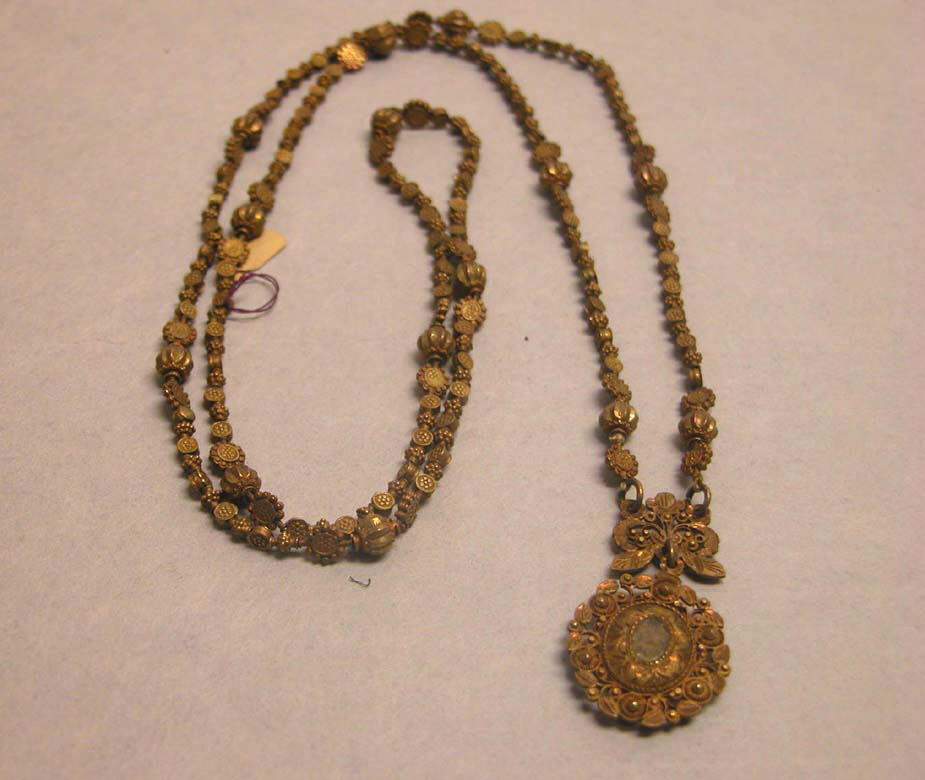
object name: necklace or rosary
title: Rosary or Necklace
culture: filipino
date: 1601-1900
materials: gold